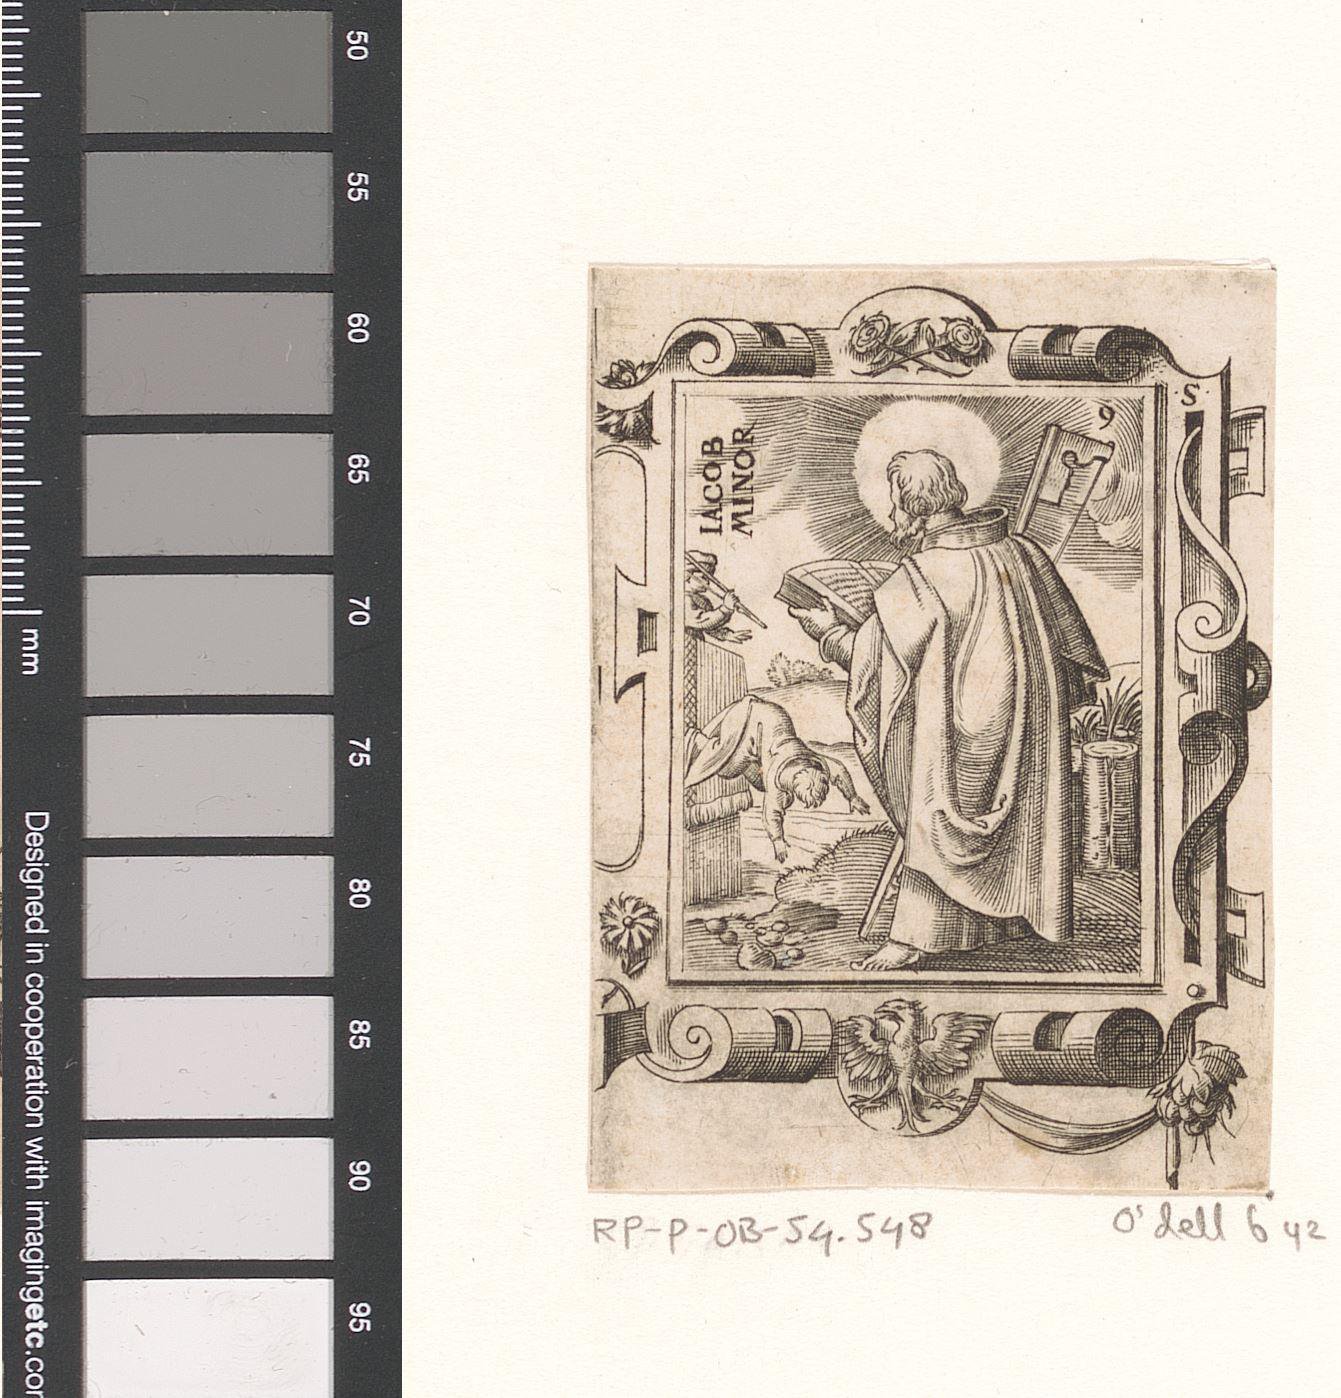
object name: print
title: Heilige Jakobus de Mindere in een rolwerk omlijsting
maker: virgilius solis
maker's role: draughtsman, print maker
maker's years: 1514-1562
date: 1568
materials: paper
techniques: engraving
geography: nuremberg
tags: scrollwork, strapwork ~ ornament, the apostle james the less, first bishop of jerusalem; possible attributes: book, fuller's club, scroll, james thrown from the roof of a temple in jerusalem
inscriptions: number: ‘87’, collector's mark: Lugt 240, collector's mark: Lugt 2228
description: Prent gebruikt voor het gebedenboek: Solis, Virgil. Ein New Künstlich Betbüchlein. Neurenberg: Hieronymus Petri, 1568. Bij elke prent met afbeelding van een apostel behoort een prent met een gebed in het Latijn en in het Duits. Bij elkaar horende prenten hebben dezelfde nummering en het monogram VS is steeds verspreid over twee bladen met dezelfde nummering.